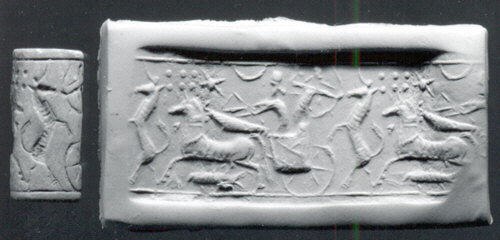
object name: cylinder seal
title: Cylinder seal with chariot hunting scene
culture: assyrian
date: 900-801 BCE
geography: levant or syria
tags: men,deer,horses,chariots